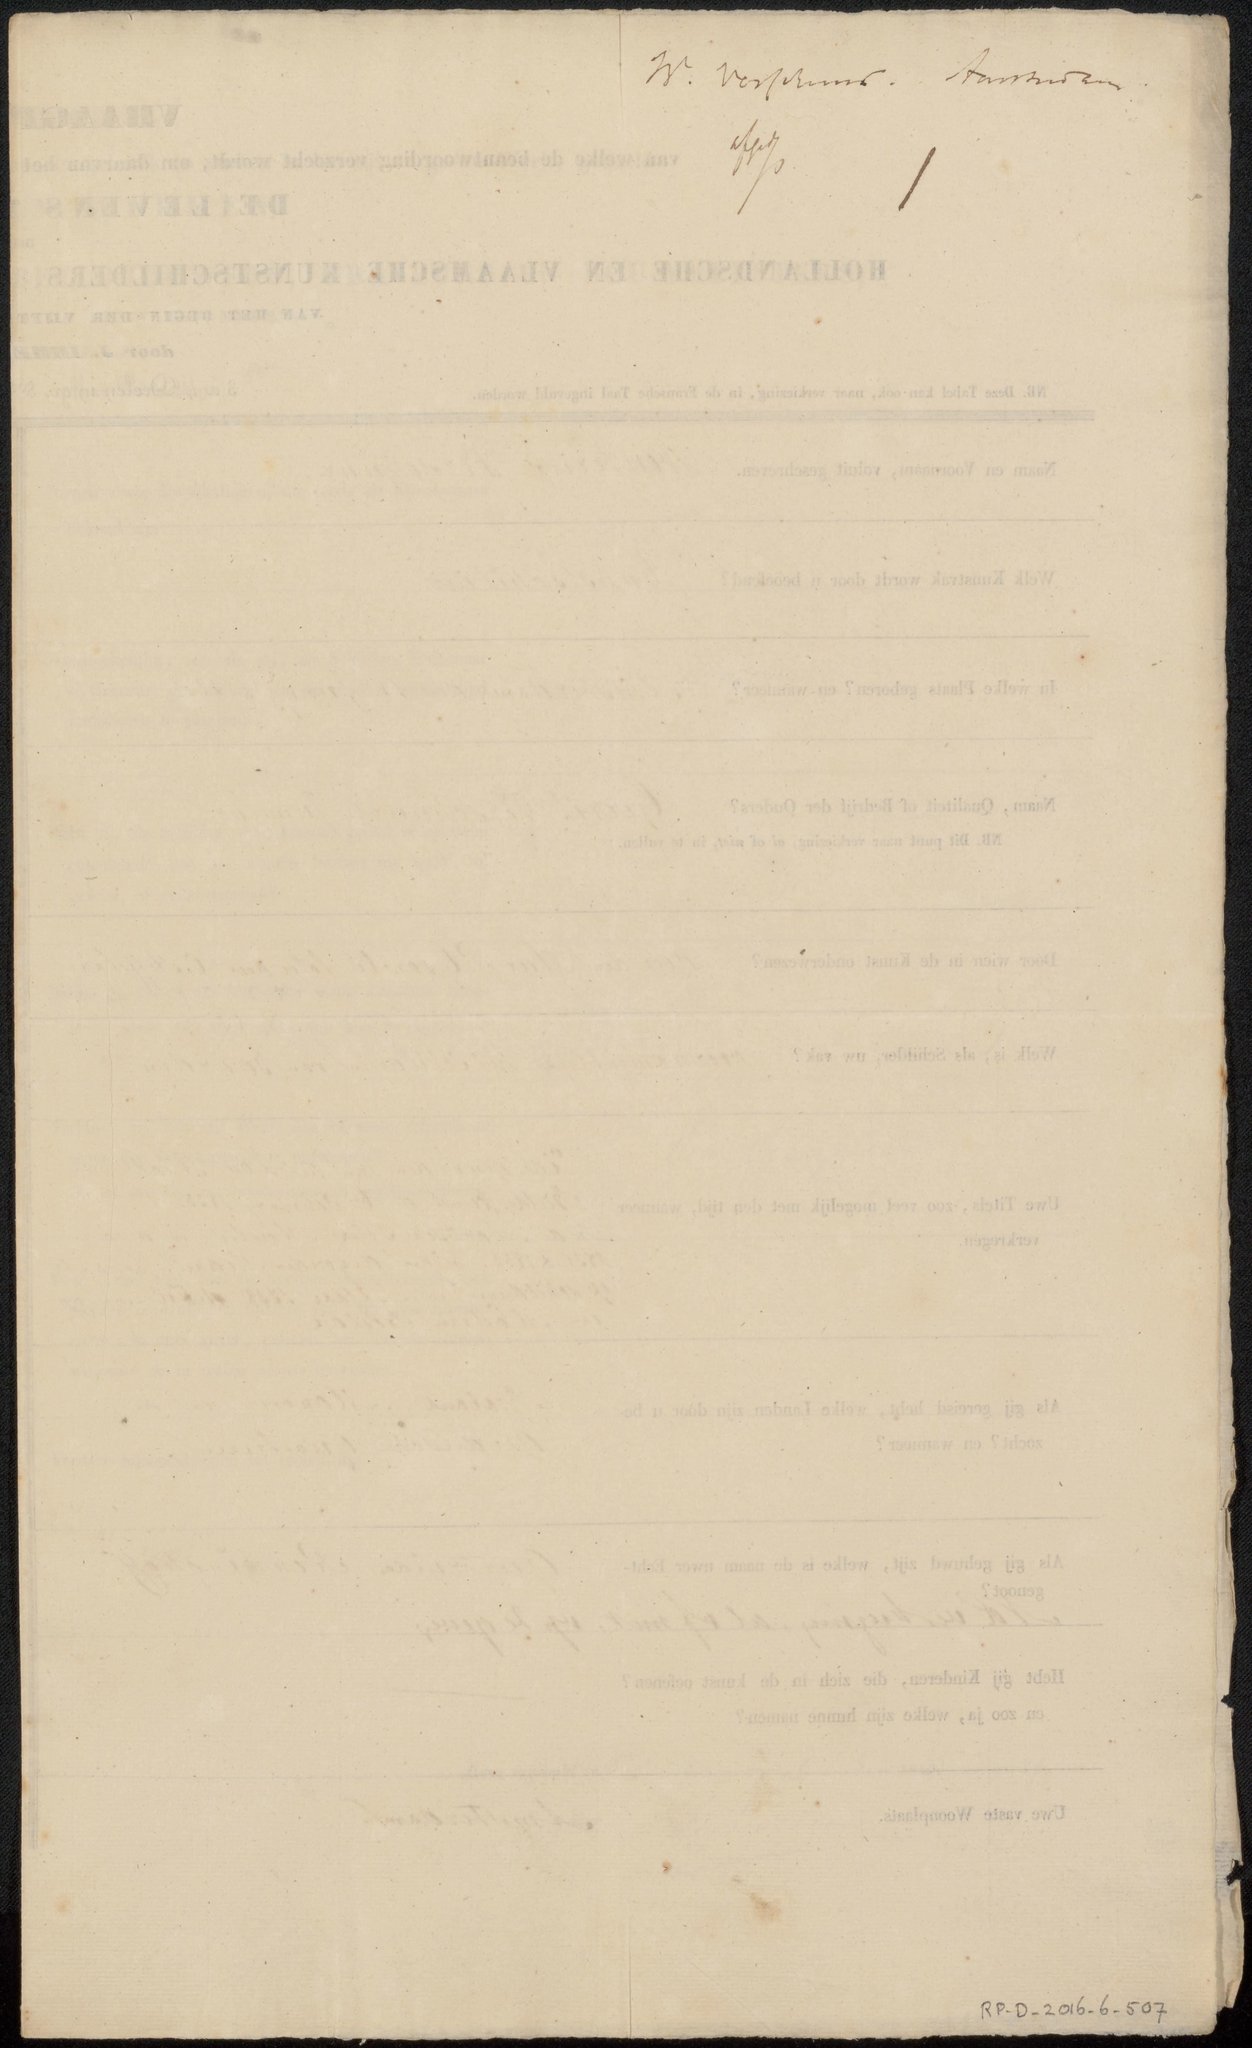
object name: questionnaire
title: Enquêteformulier ingevuld door Wouter Verschuur (1812-1874)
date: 1840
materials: ink, paper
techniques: pen, printing, writing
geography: amsterdam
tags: amsterdam, painter, print maker, draughtsman, wouter verschuur (1812-1874)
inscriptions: inscription: ‘Vraagpunten,/ van welke de beantwoording verzocht wordt, om daarvan het noodig gebruik te maken in het uit te geven Werk, getiteld: De levens en werken/ der Hollandsche en Vlaamsche kunstschilders, beeldhouwers,/ graveurs en bouwmeesters, van het begin der vijftiende eeuw tot heden/ door J. Immerzeel, Jr.’, watermark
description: Opgenomen in: Immerzeel, J. Jr., De levens en werken der Hollandsche en Vlaamsche kunstschilders, beeldhouwers, graveurs en bouwmeesters, van het begin der vijftiende eeuw tot heden, Amsterdam: J.C. van Kesteren, 1842-1843.